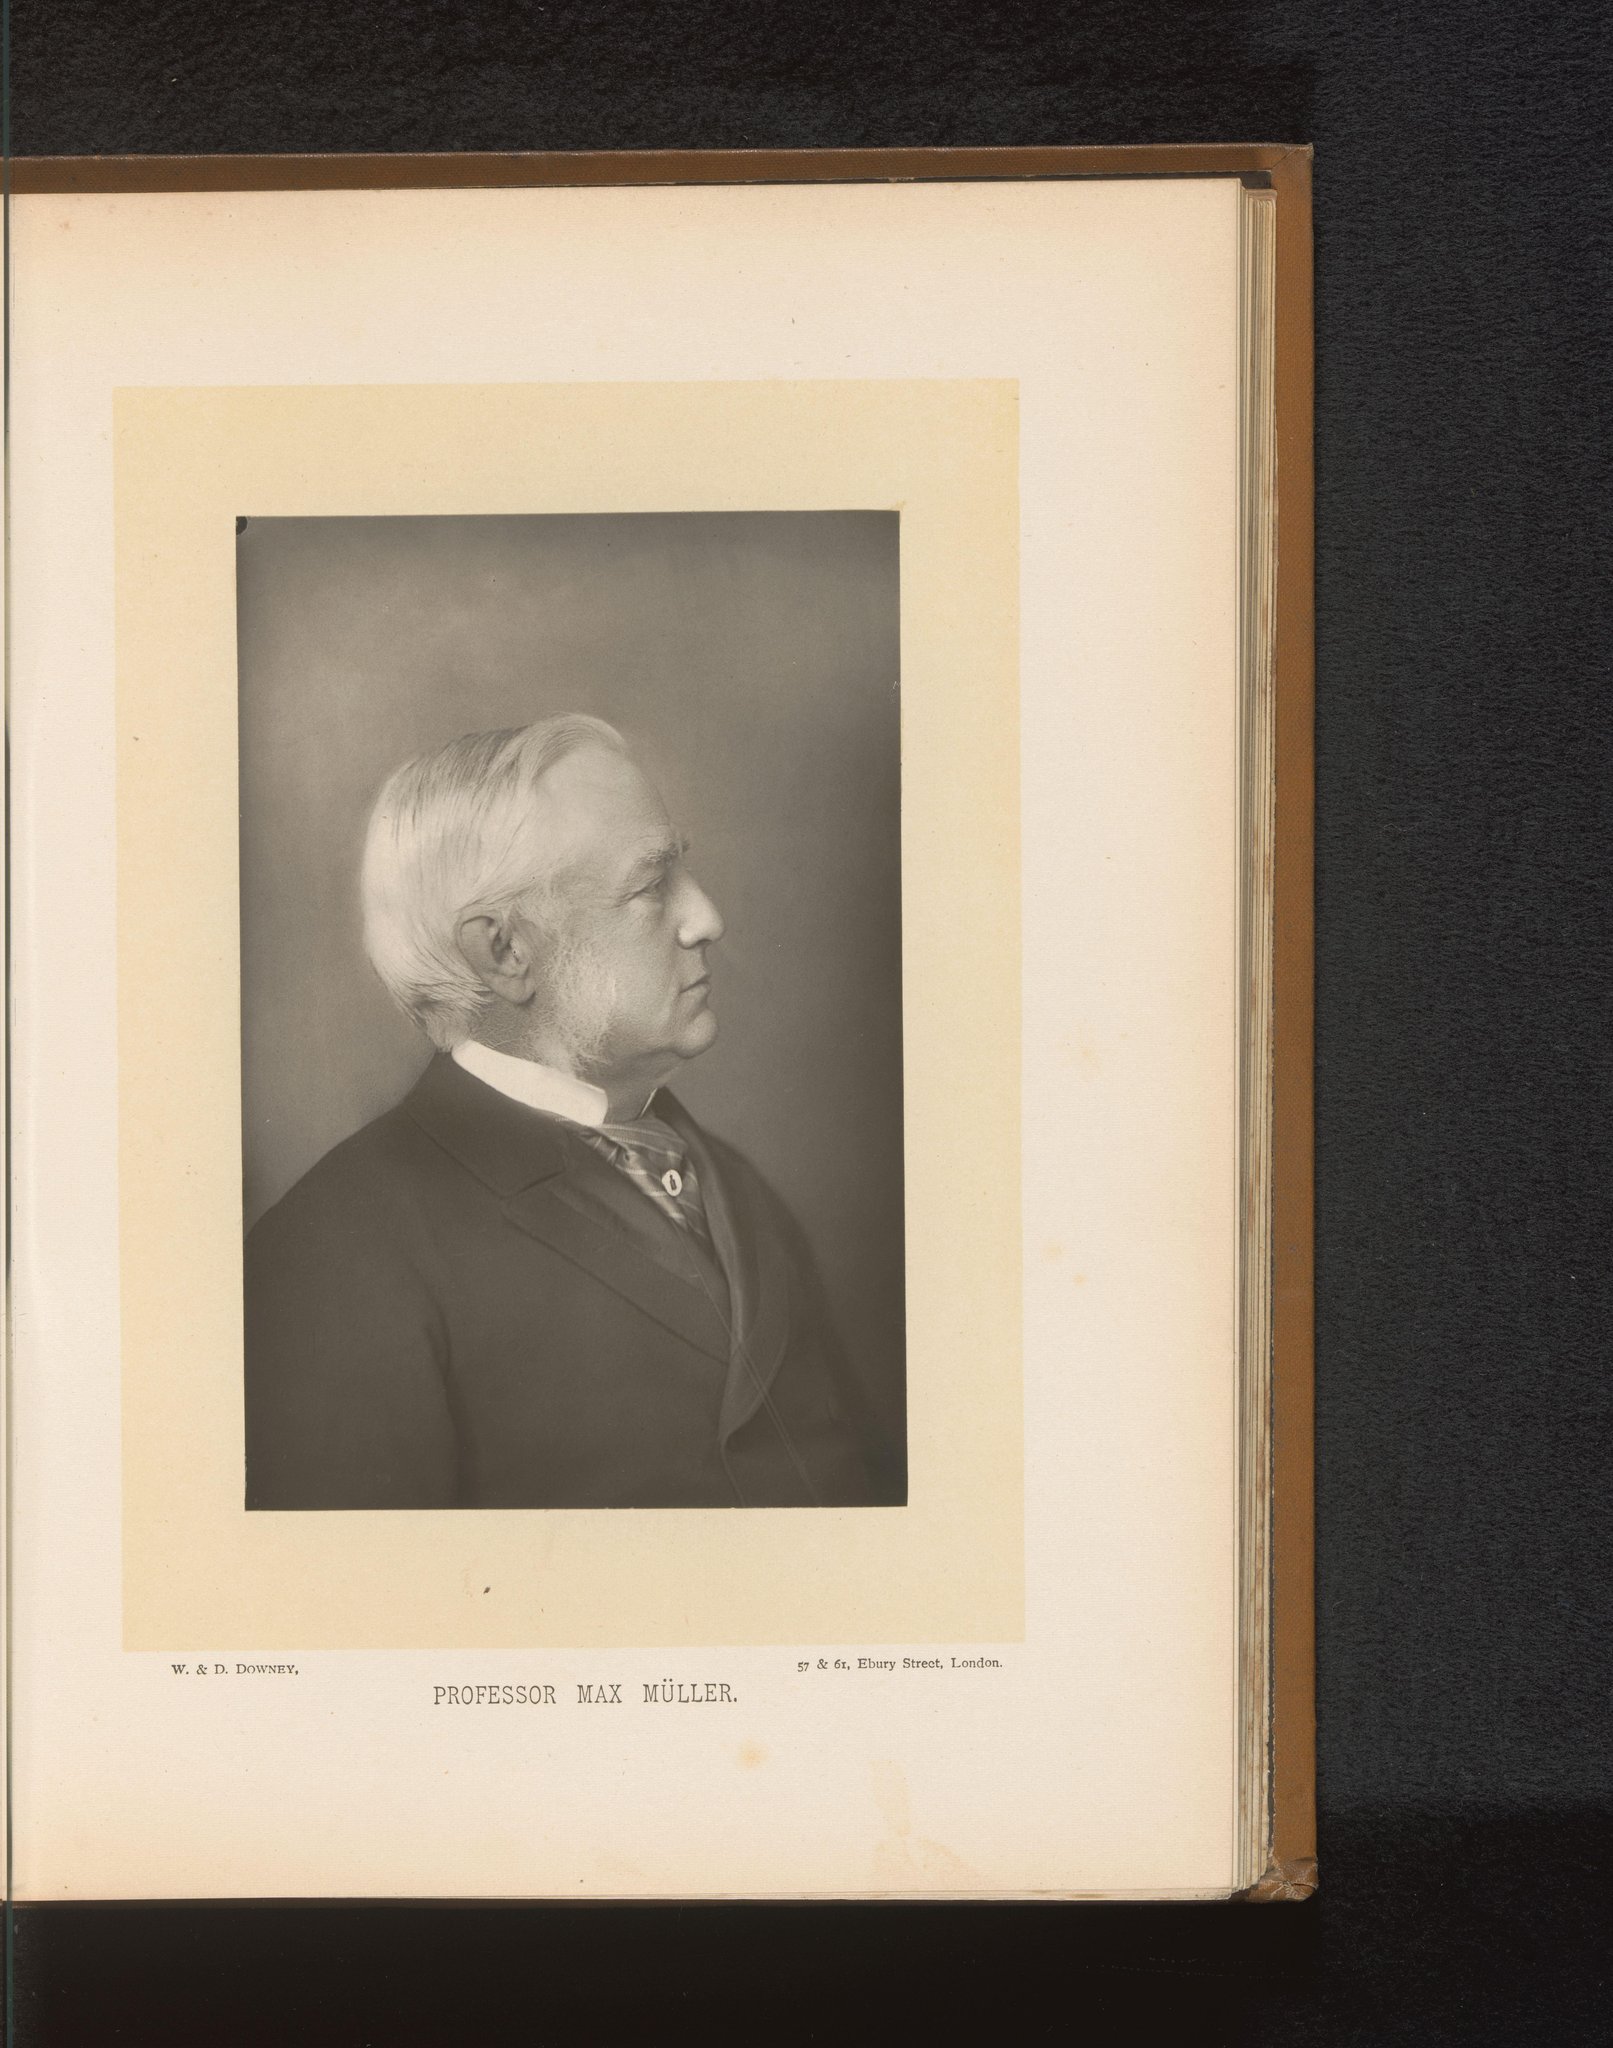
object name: photomechanical print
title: Portret van Max Müller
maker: Anonymous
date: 1883-1893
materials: paper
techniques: woodburytype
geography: london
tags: scholar, philosopher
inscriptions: inscription: ‘57 & 61, Elbury Street, London.’